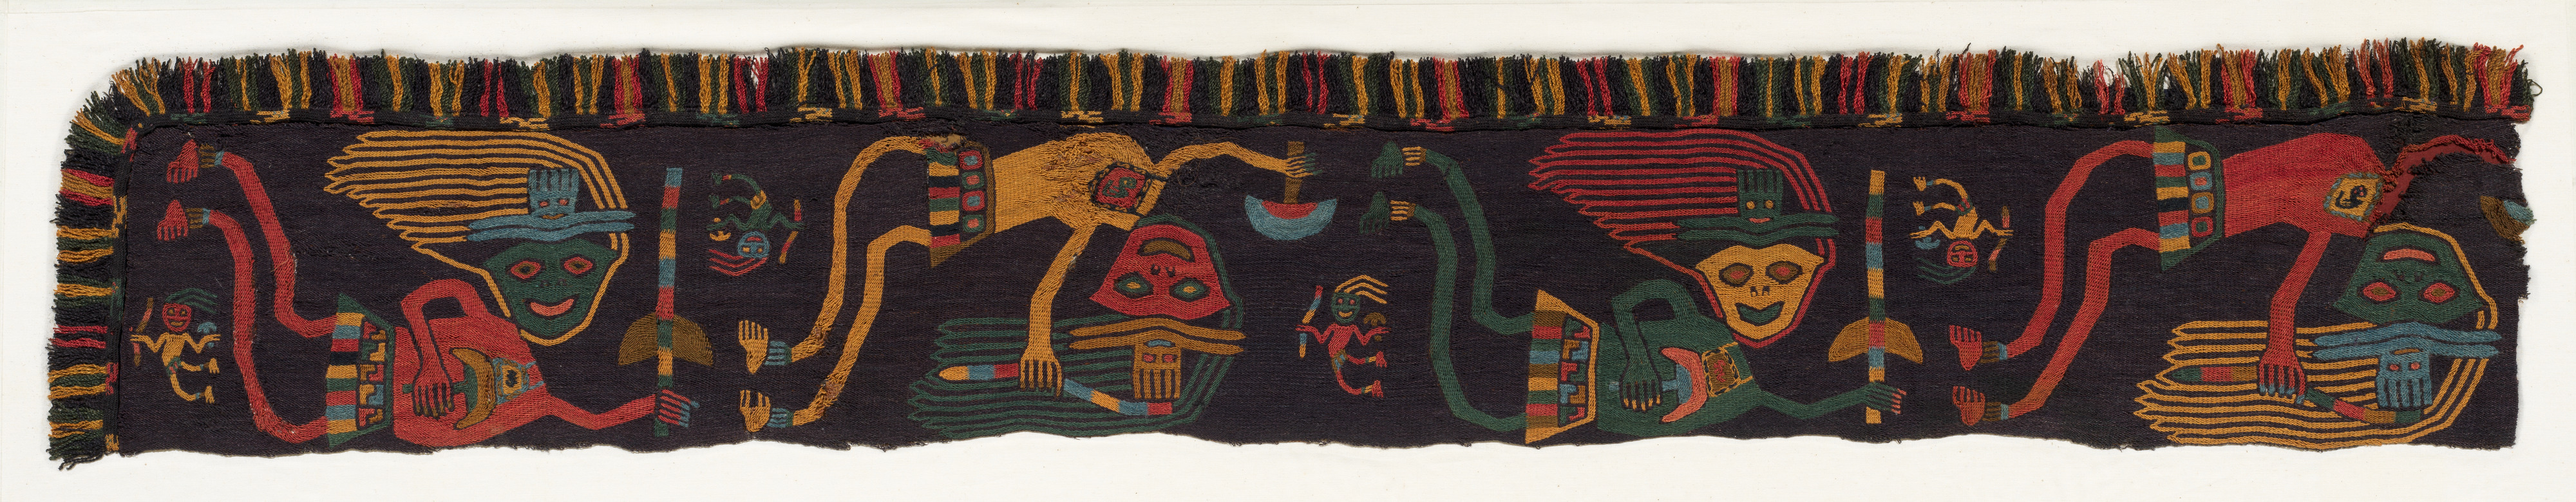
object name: border fragment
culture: paracas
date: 450-175 BCE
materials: animal fiber, cotton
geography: peru